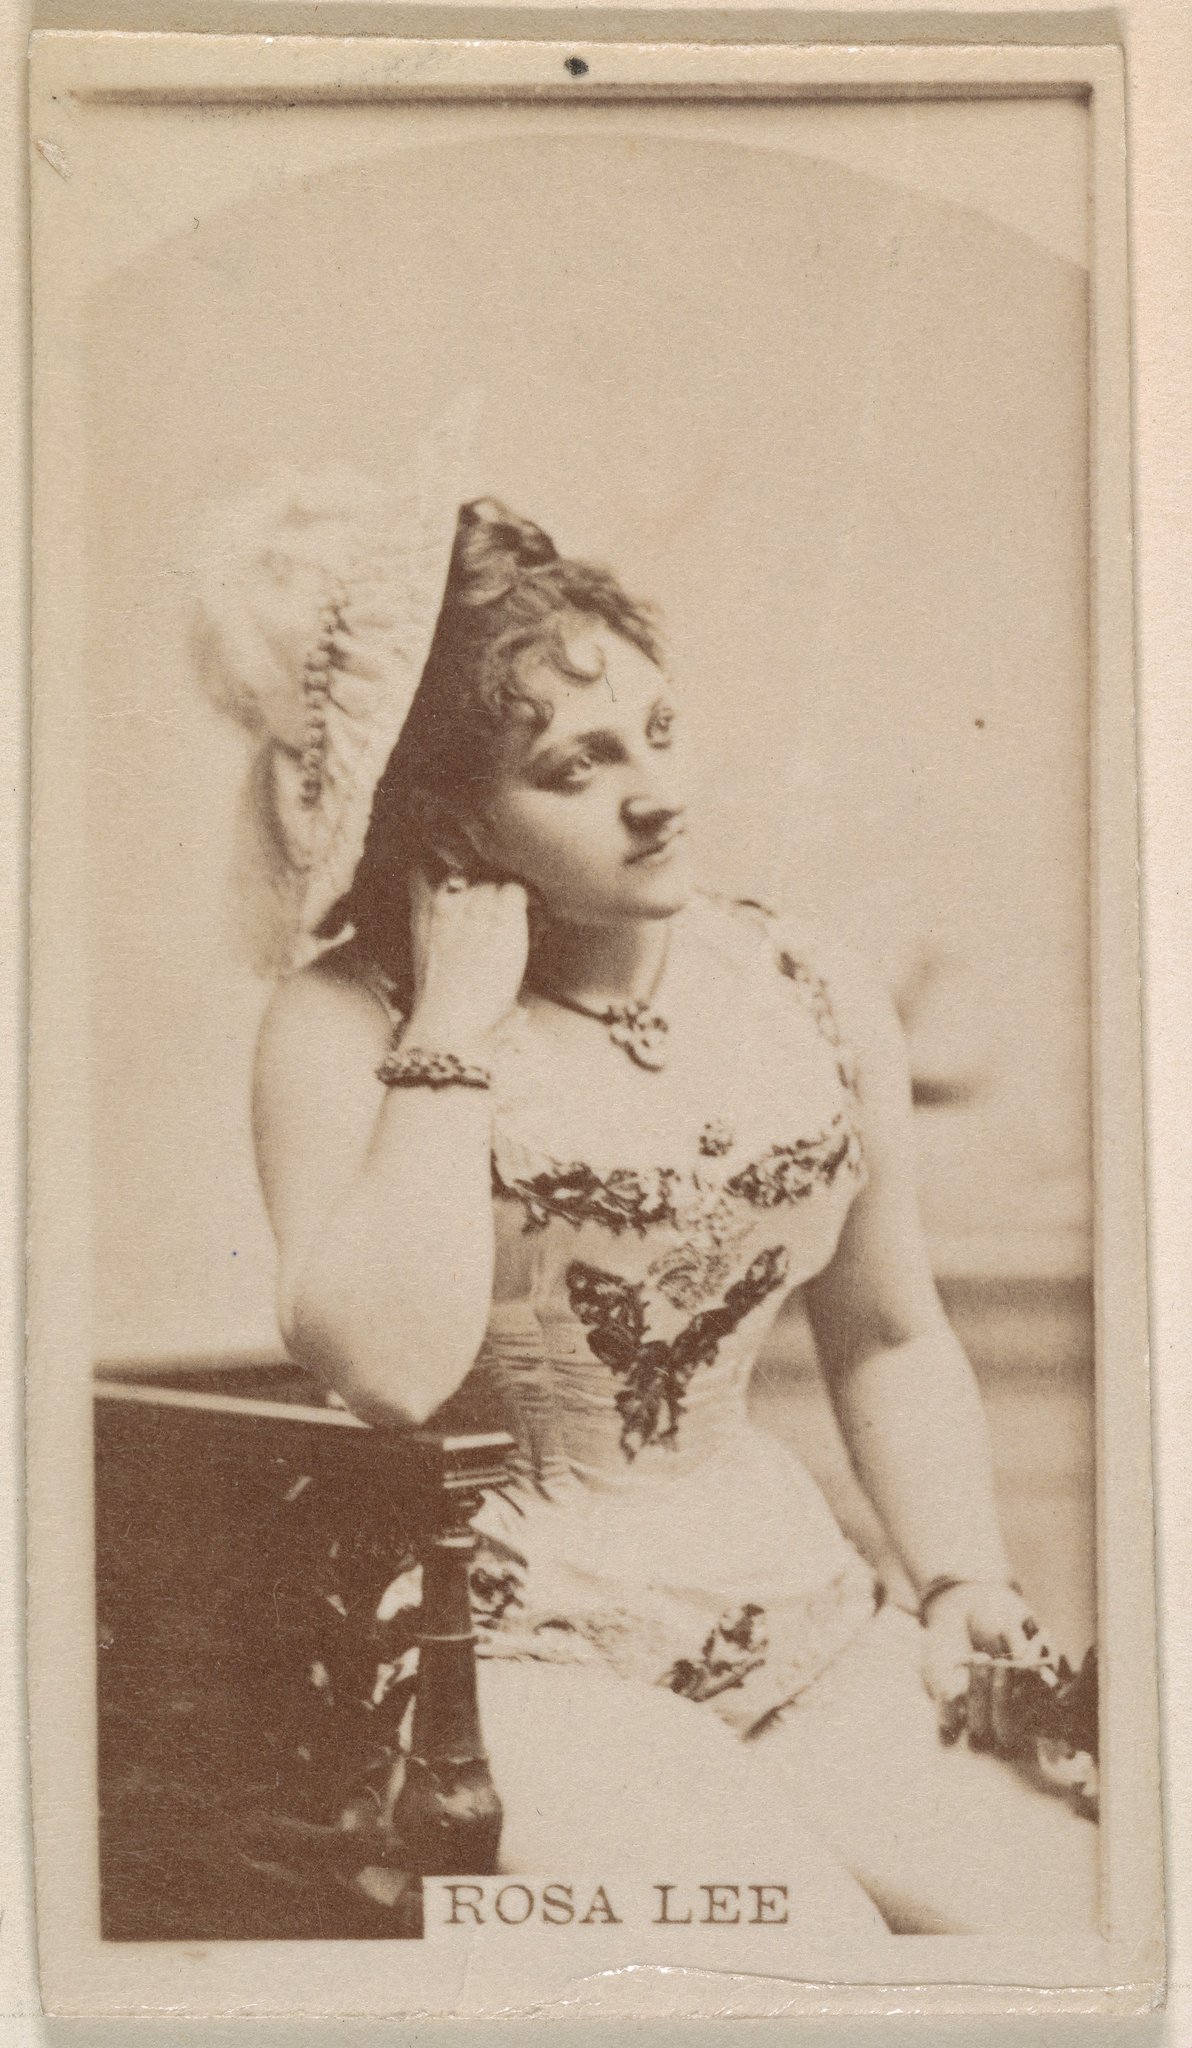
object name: photograph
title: Rosa Lee, from the Actresses series (N245) issued by Kinney Brothers to promote Sweet Caporal Cigarettes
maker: kinney brothers tobacco company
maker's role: publisher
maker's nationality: american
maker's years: 1869-2011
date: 1890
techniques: albumen silver print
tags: portraits,women,actresses